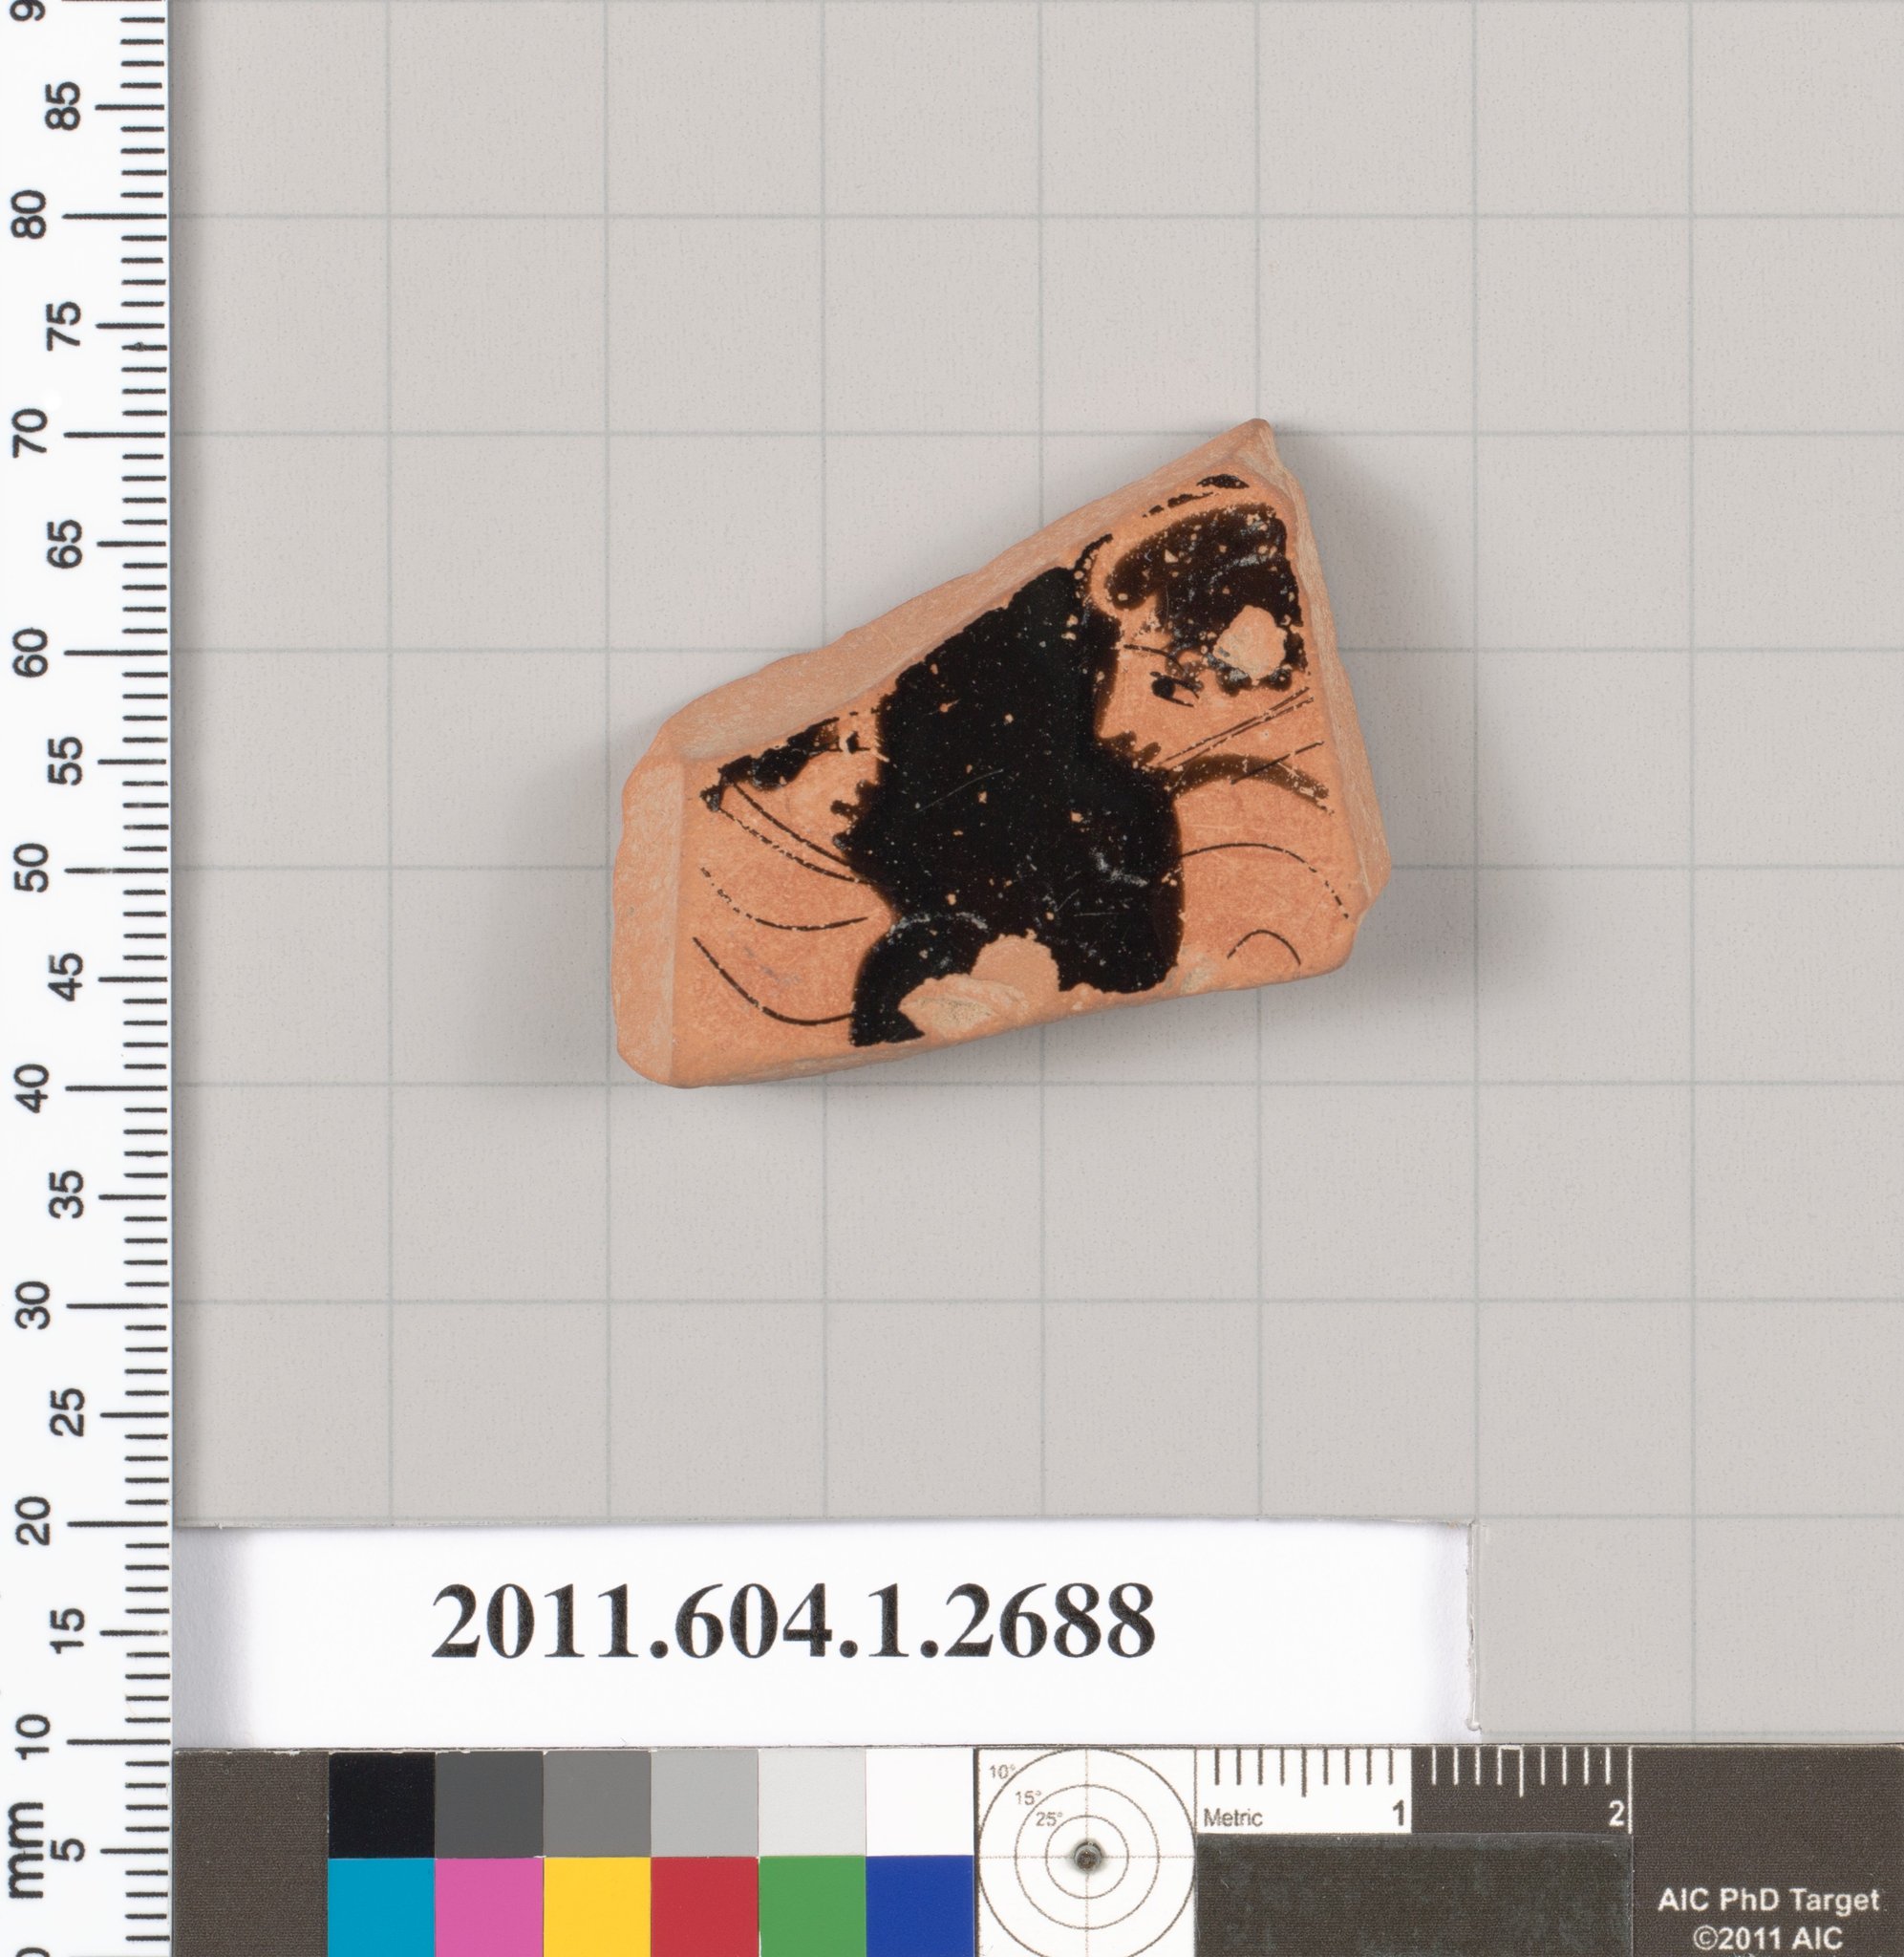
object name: kylix fragment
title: Terracotta fragment of a kylix (drinking cup)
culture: greek, attic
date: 467-435 BCE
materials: terracotta